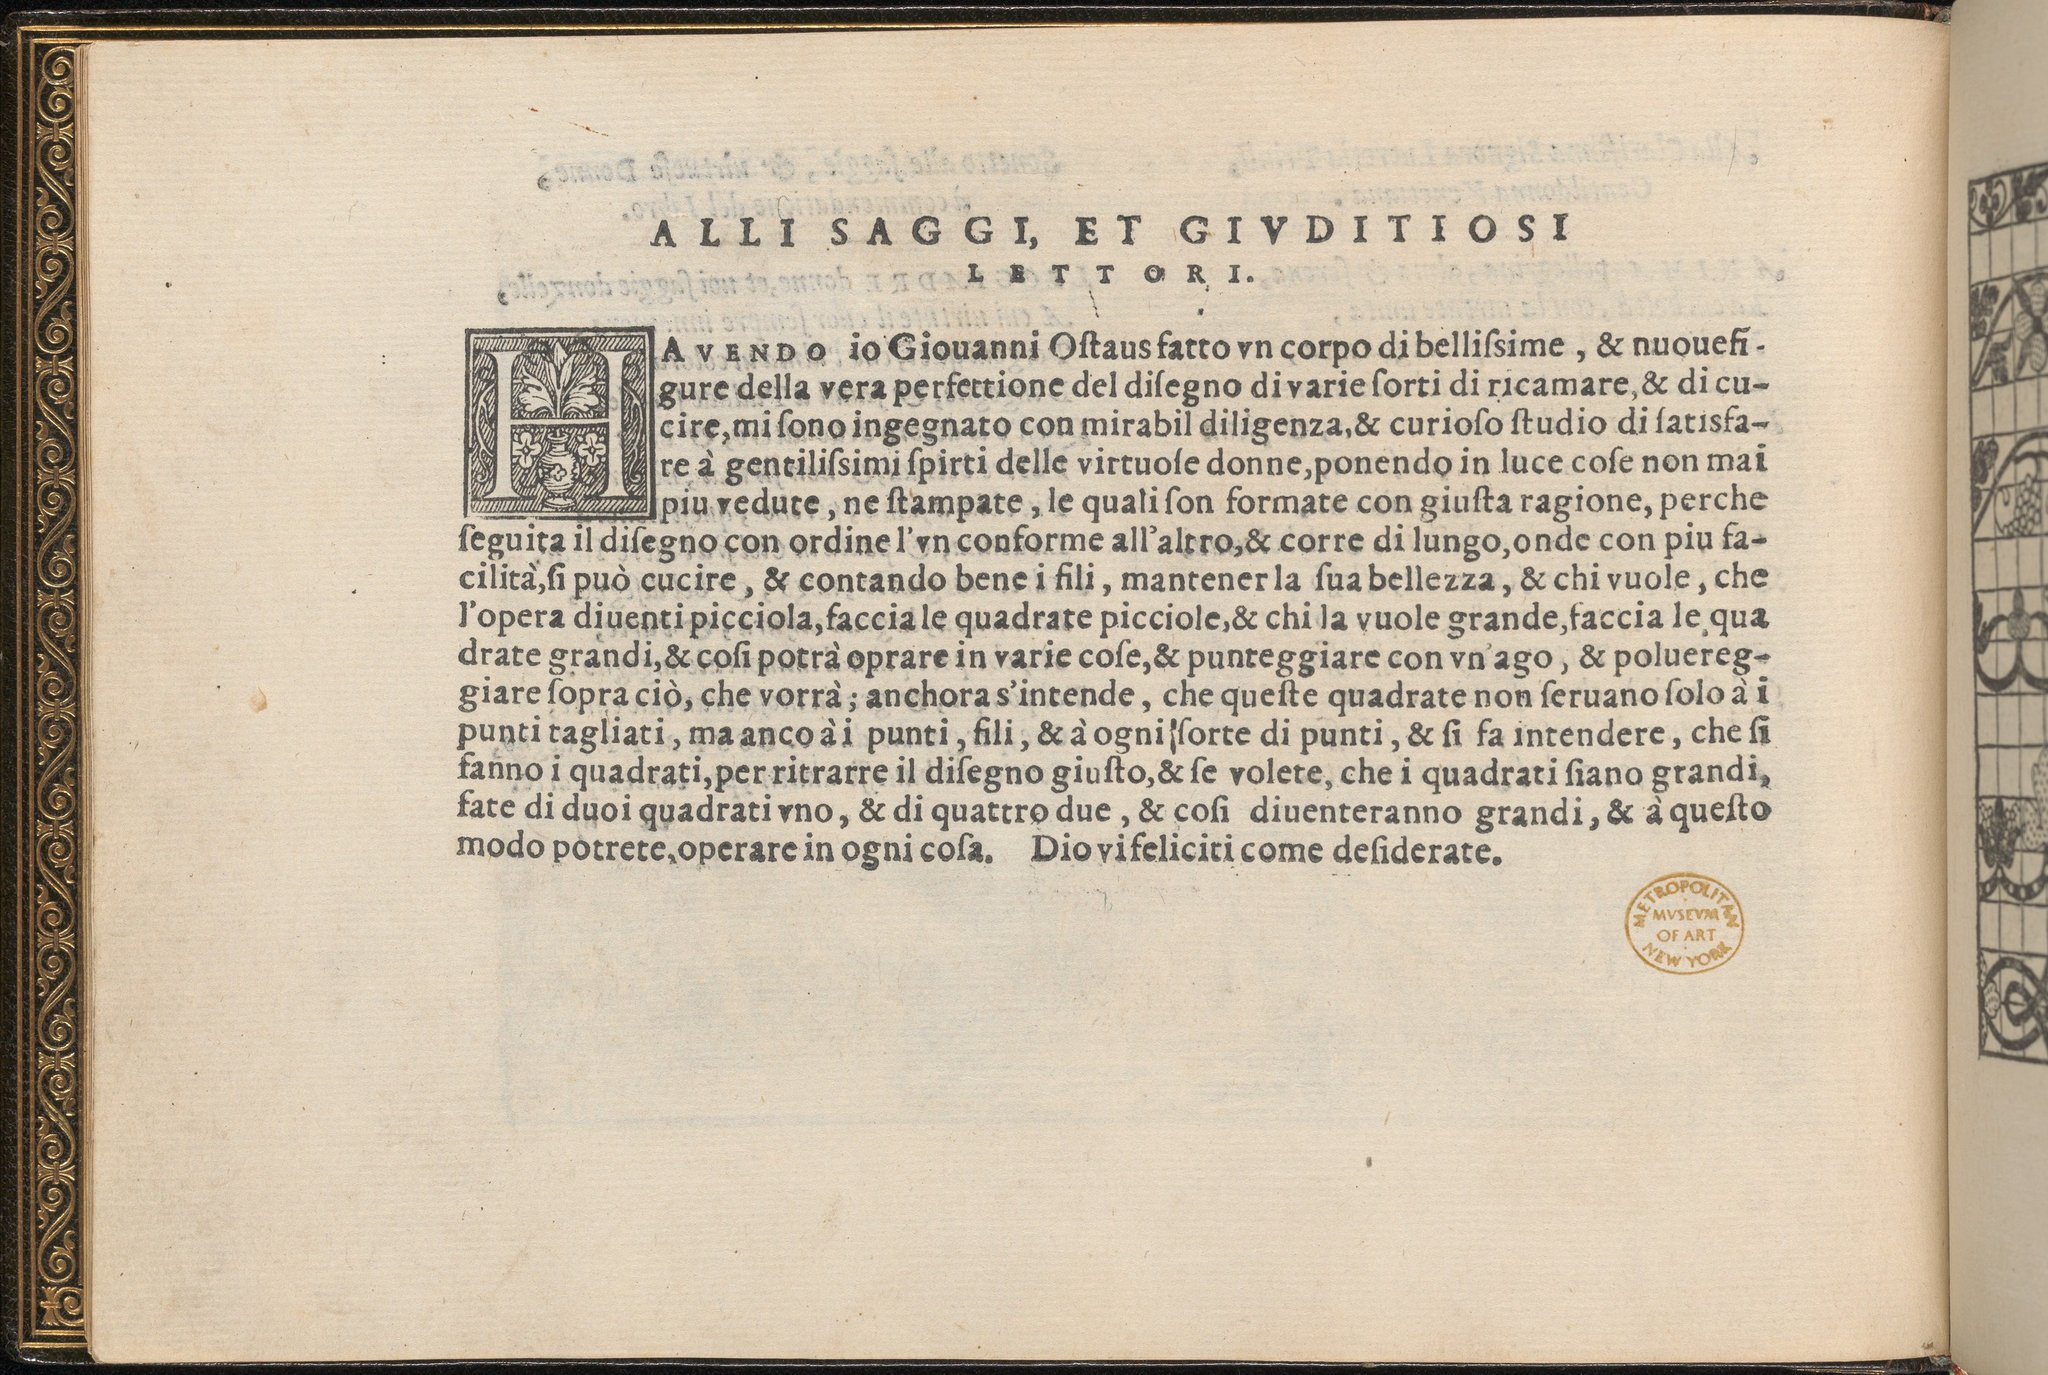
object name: book print ornament architecture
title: La Vera Perfettione del Disegno di varie sorti di recami, page 3 (verso)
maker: giovanni ostaus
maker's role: publisher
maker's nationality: italian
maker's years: 1507-1607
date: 1567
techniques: woodcut